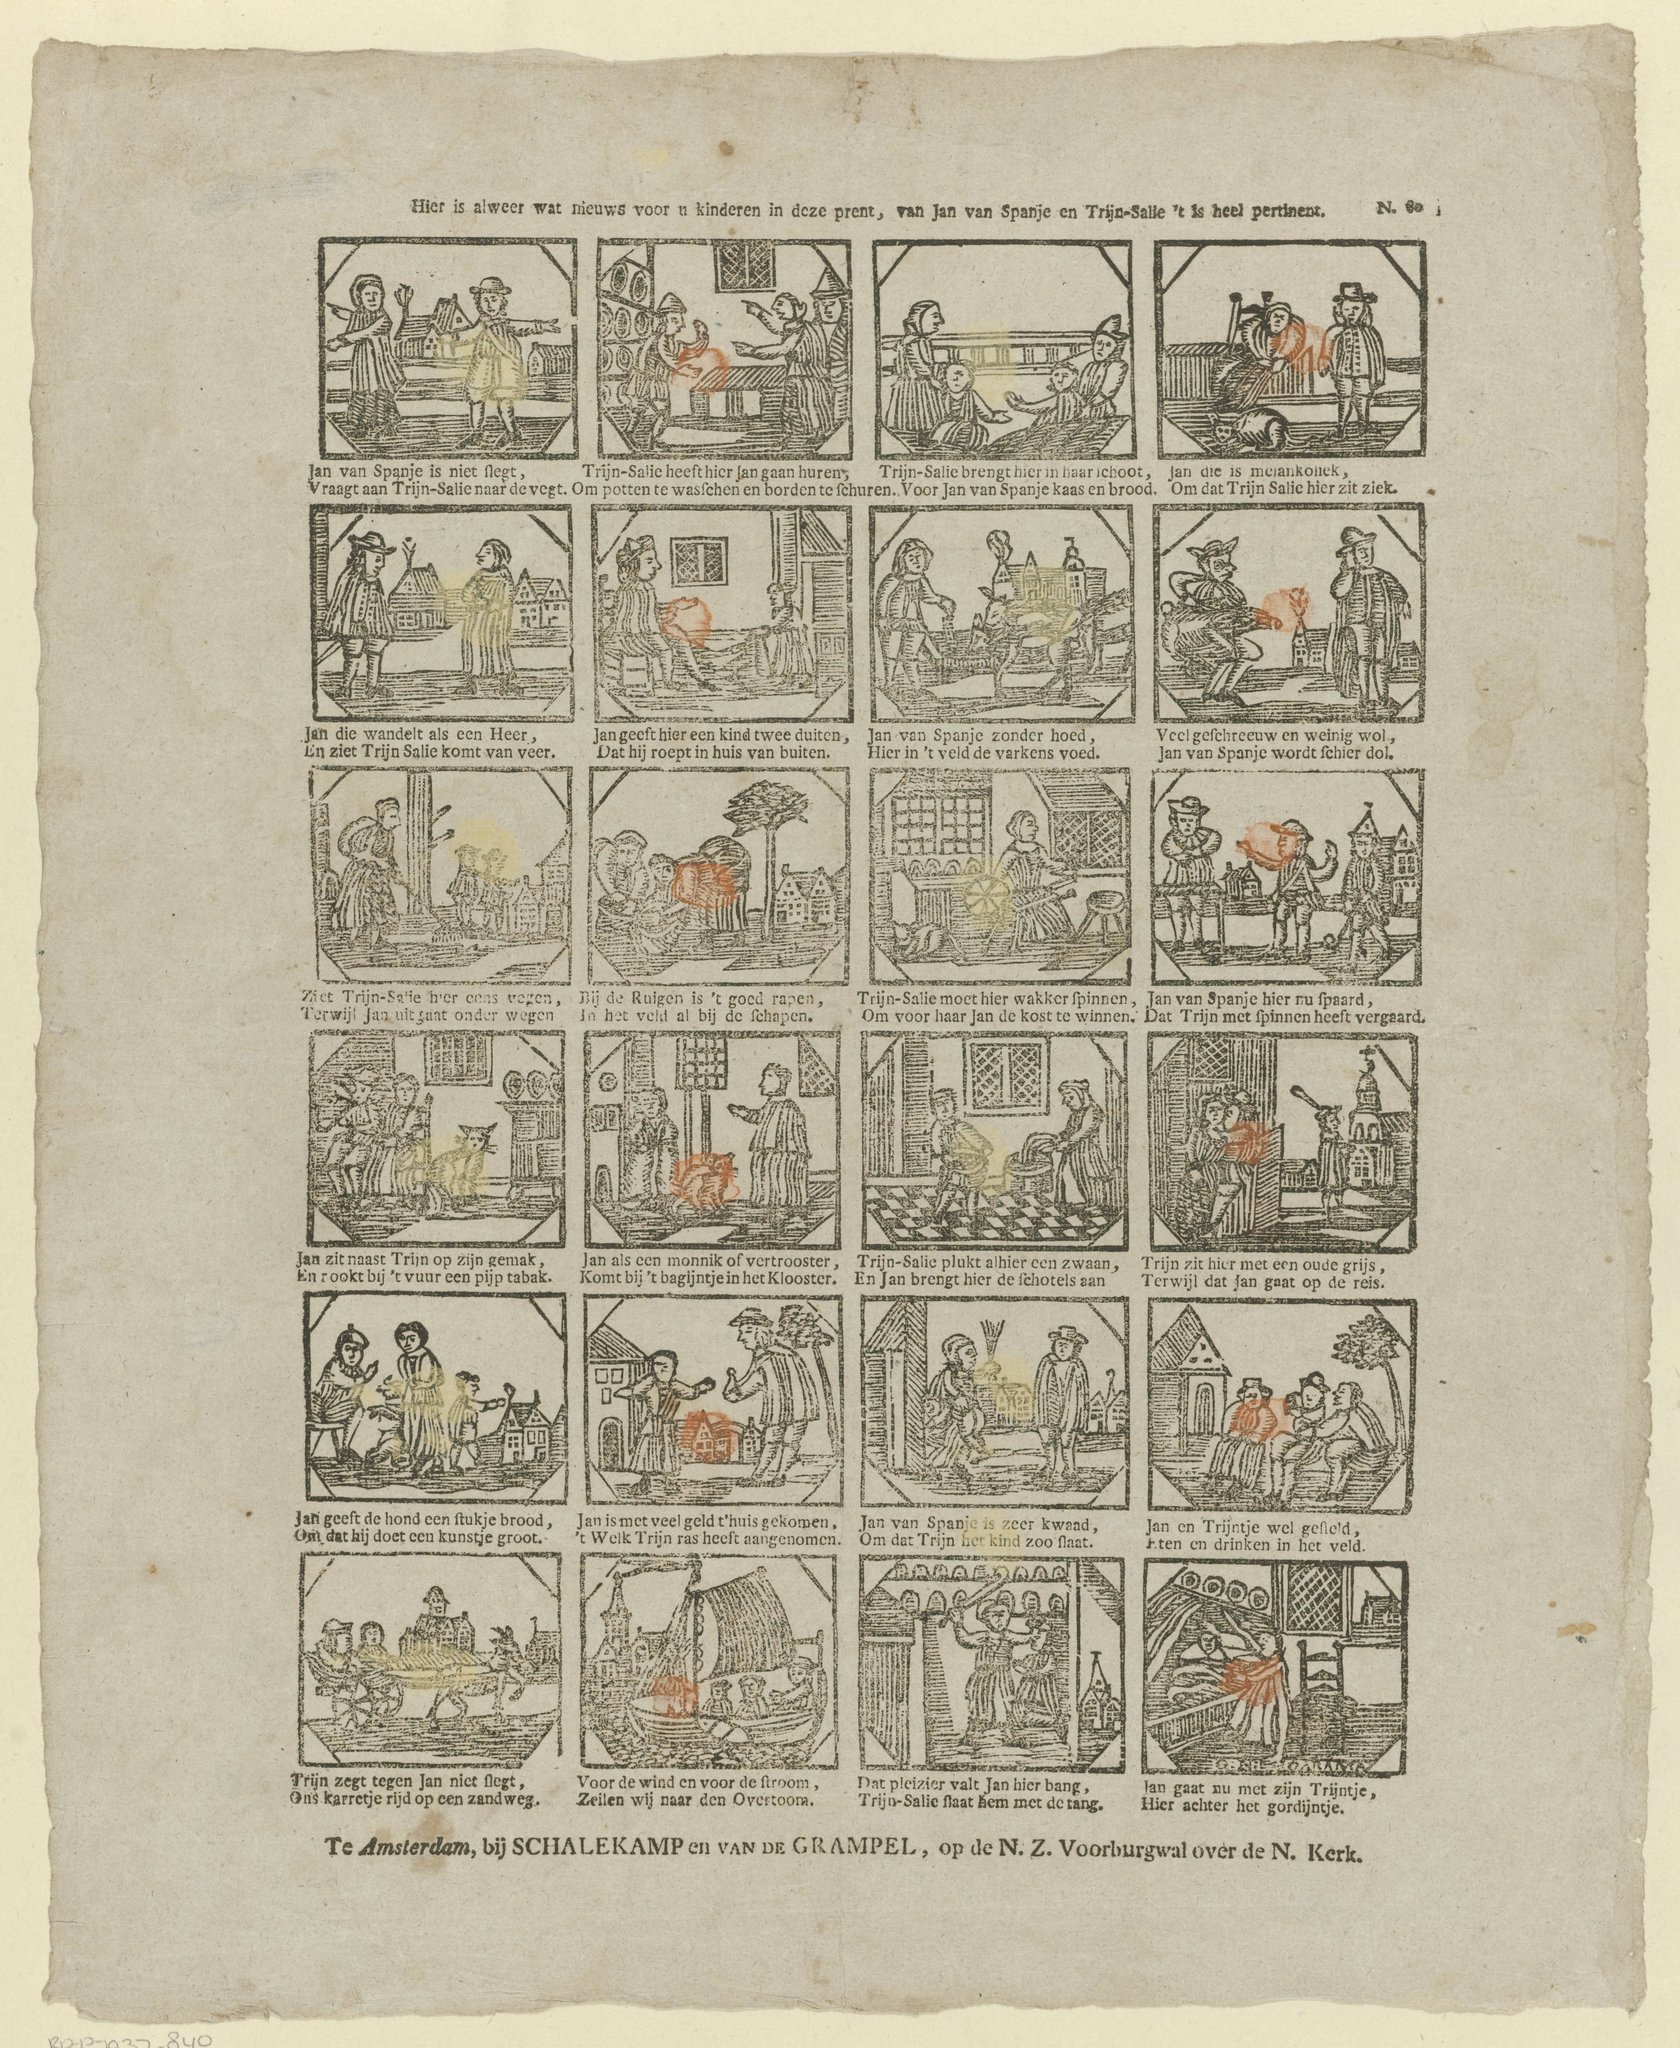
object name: print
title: Hier is alweer wat nieuws voor u kinderen in deze prent, van Jan van Spanje en Trijn-Salle 't is heel pertinent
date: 1822-1837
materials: paper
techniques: letterpress printing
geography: amsterdam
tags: battle for dominance in marriage ('who wears the breeches'), tales and fairy tales, lovers' tiff, quarrel, sulk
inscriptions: collector's mark: Lugt 2228, collector's mark: Lugt 2760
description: Blad met 24 voorstellingen over het leven van Jan van Spanje en Trijn Salie. Onder elke afbeelding een tweeregelig vers. Genummerd rechtsboven: N. 80.